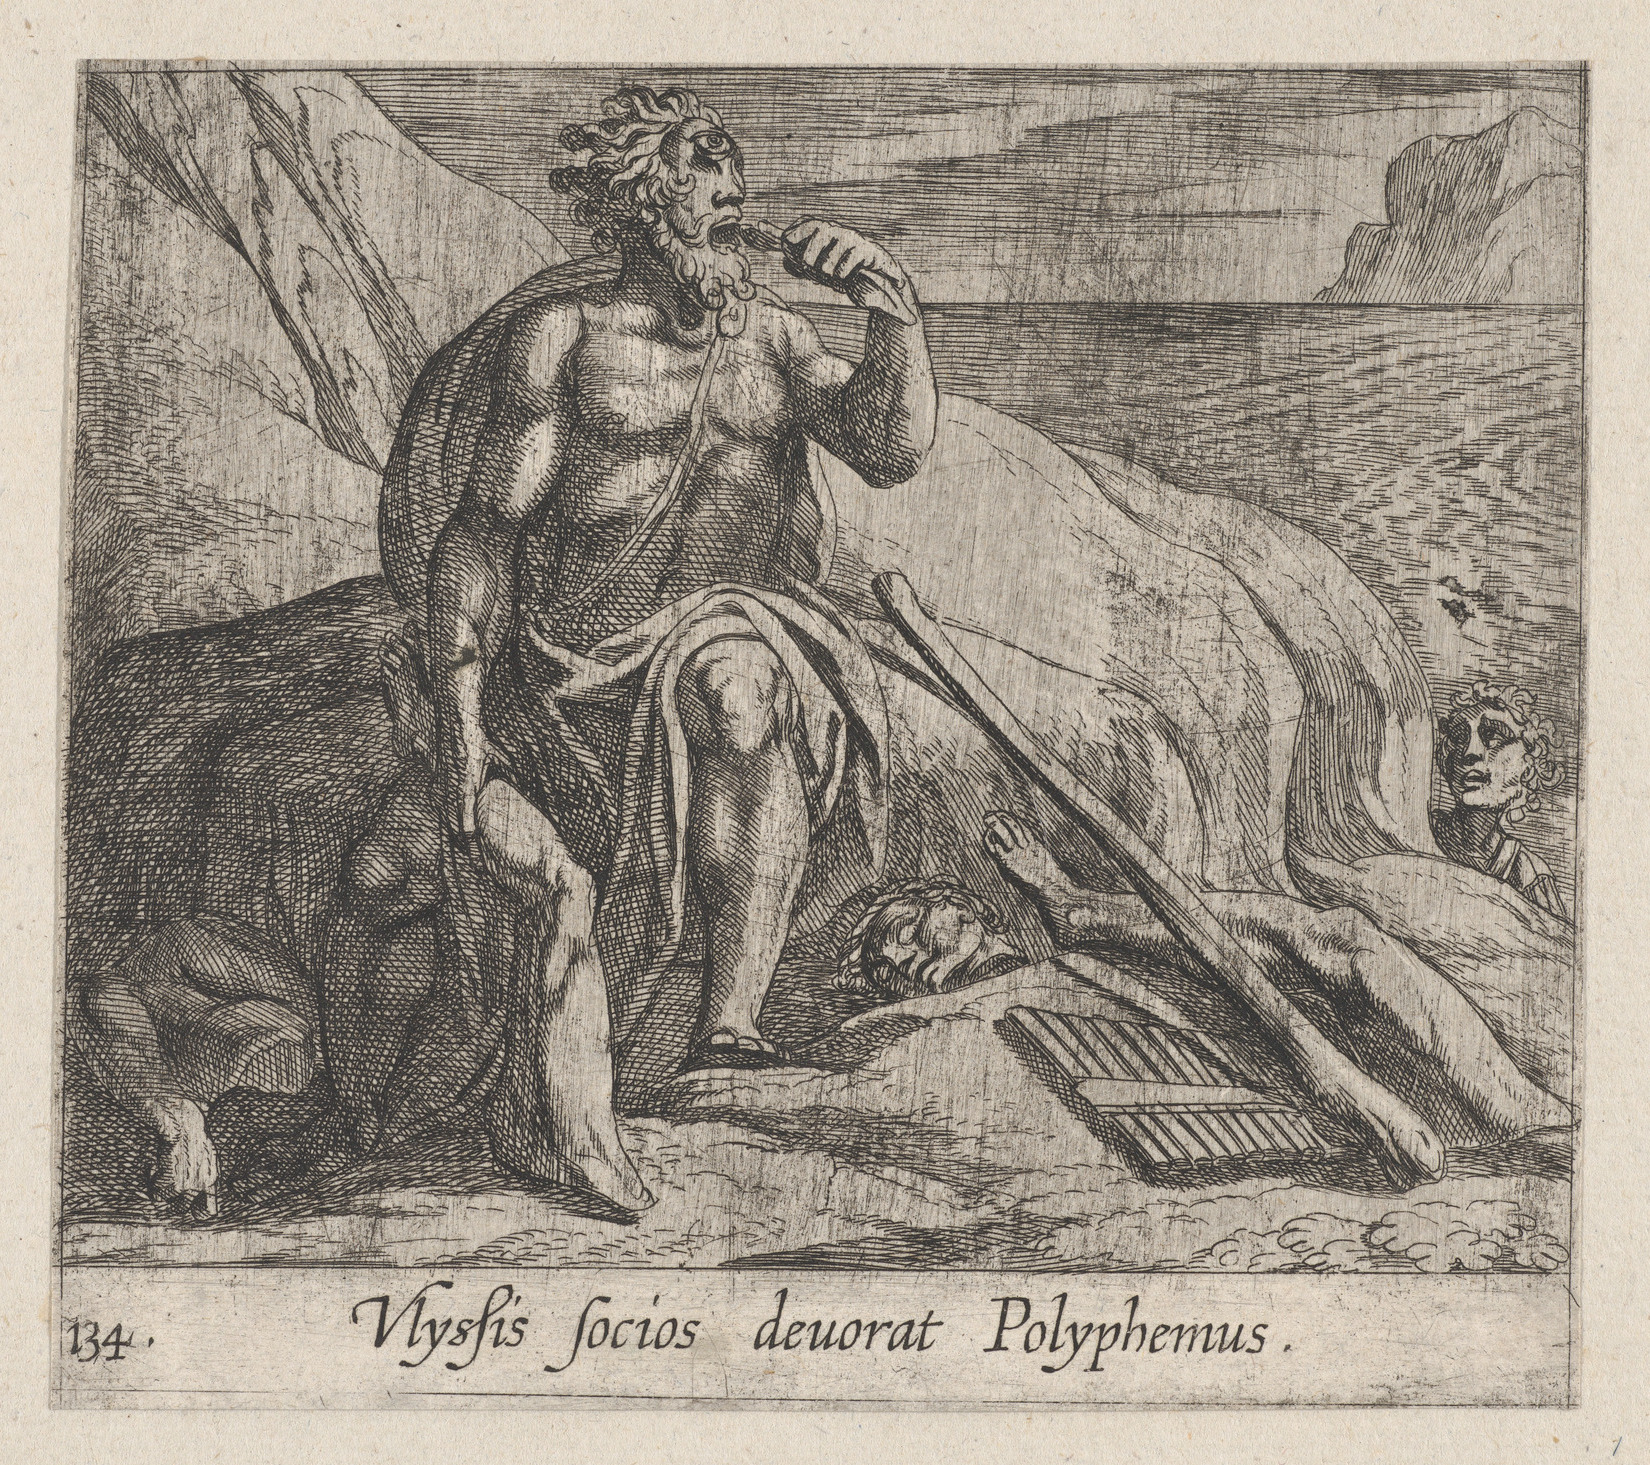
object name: print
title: Plate 143: Polyphemus Eating Ulysses' Men, as Achaemides Watches (Ulyssis socios deuorat Polyphemus), from Ovid's 'Metamorphoses'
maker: antonio tempesta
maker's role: artist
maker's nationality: italian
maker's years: 1555-1630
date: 1606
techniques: etching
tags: men